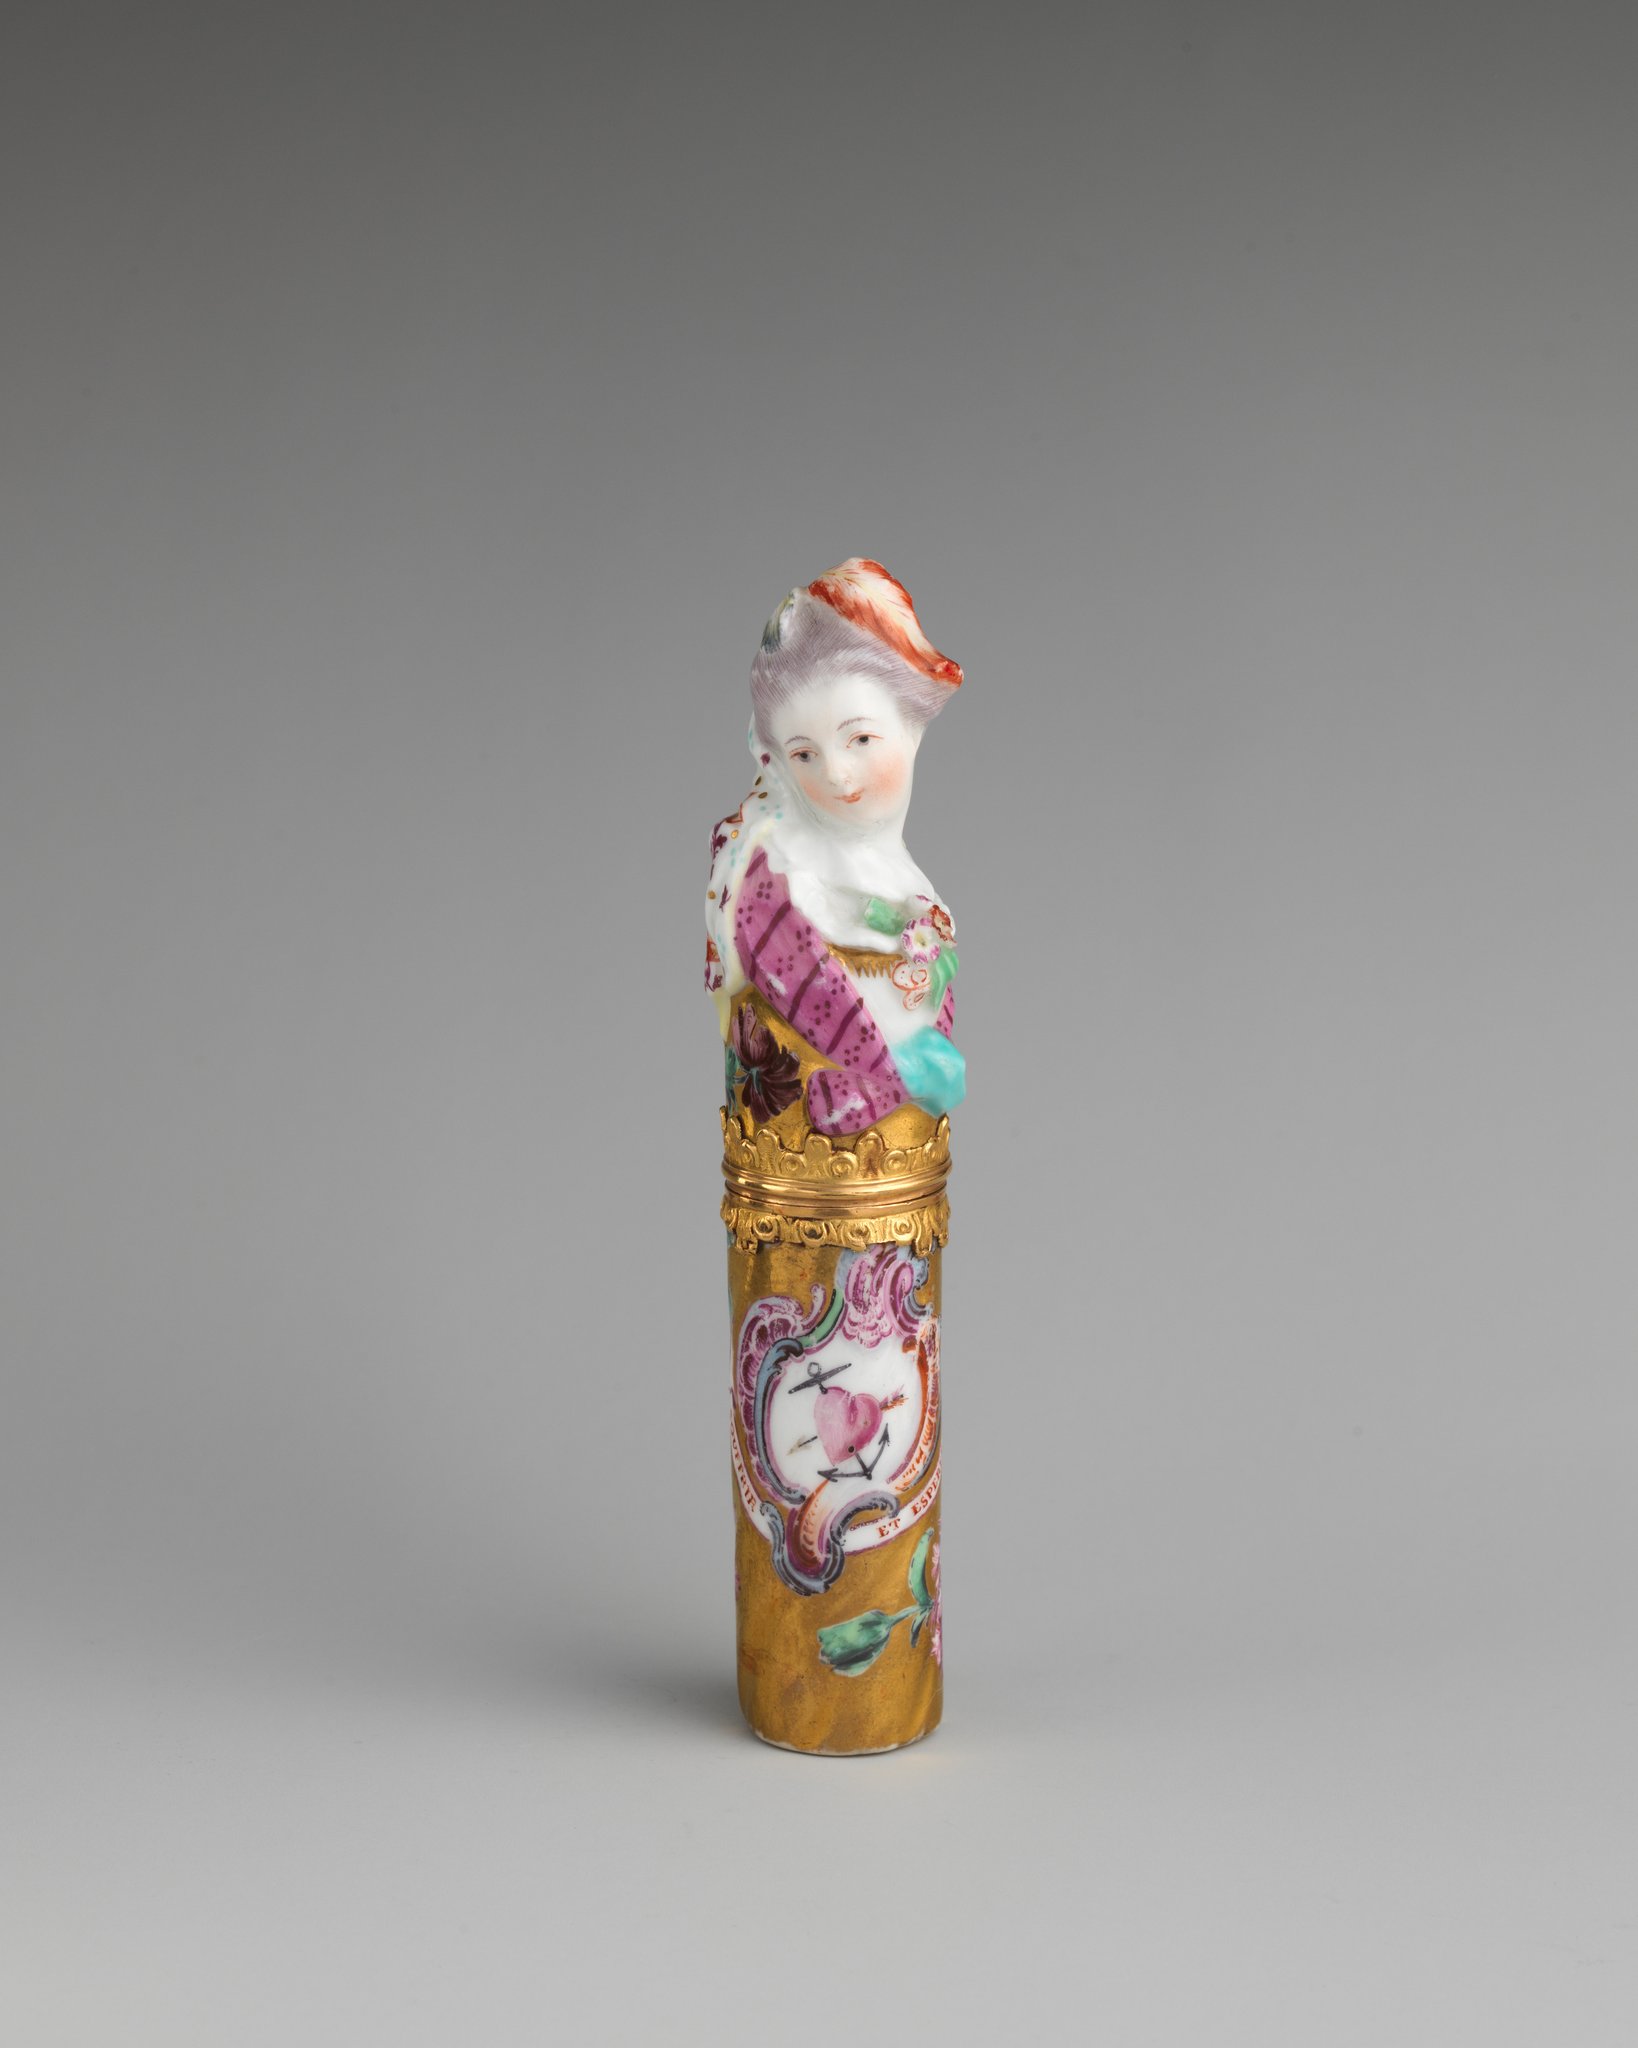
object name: toy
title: Female bust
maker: chelsea porcelain manufactory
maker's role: factory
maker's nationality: british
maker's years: 1744-1784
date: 1765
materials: soft paste porcelain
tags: women